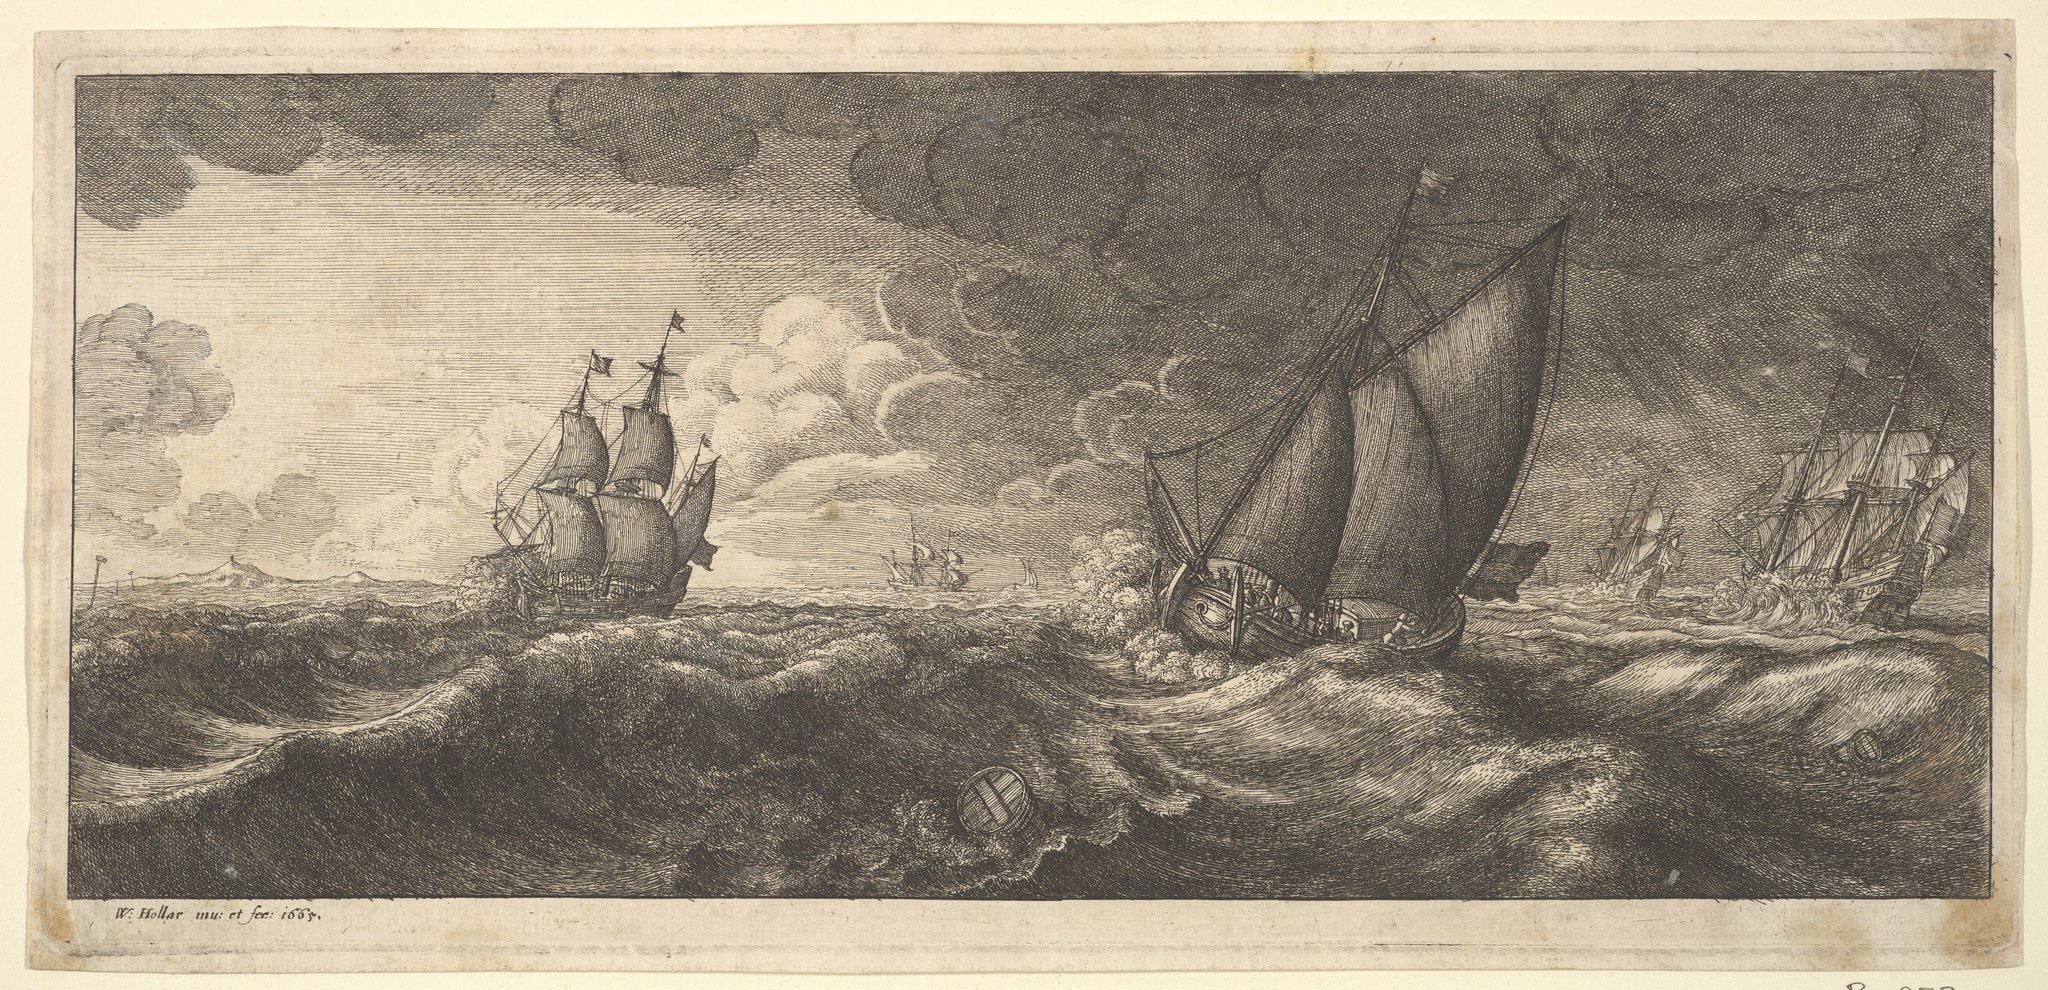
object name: print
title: A yacht and three warships in a storm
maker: wenceslaus hollar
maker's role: artist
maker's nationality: bohemian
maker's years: 1607-1677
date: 1665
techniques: etching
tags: waves,storms,ships